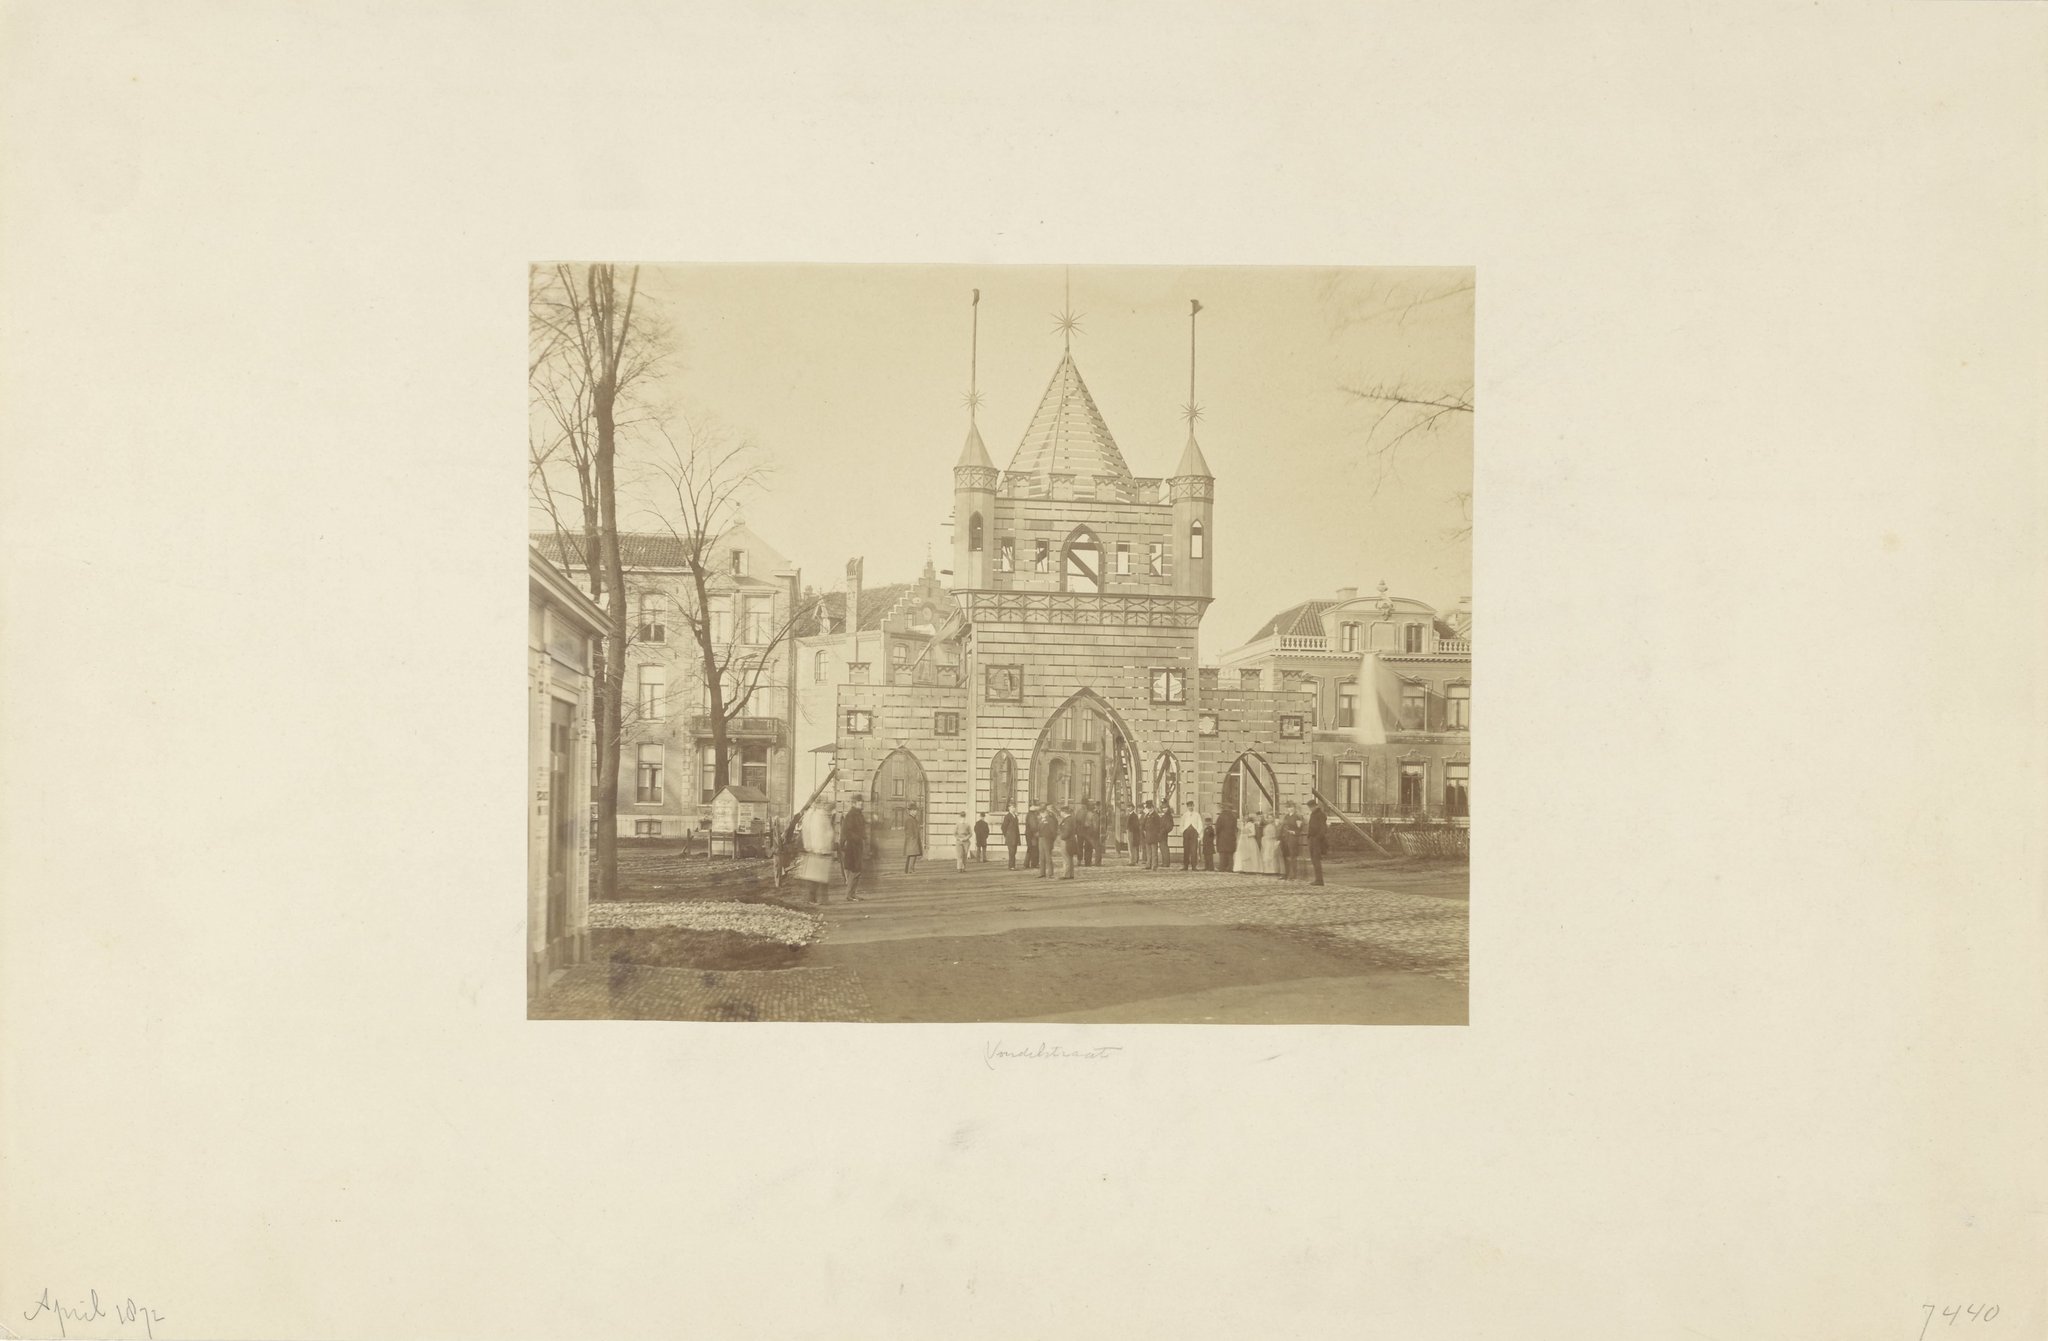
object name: photograph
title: Erepoort bij de ingang van de Vondelstraat te Amsterdam tijdens het Aprilfeest 1872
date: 1872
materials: cardboard, paper, photographic support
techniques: albumen print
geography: amsterdam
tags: public festivities (+ decorated staff, portable structure ~ festive activities), triumphal arch, gate, entrance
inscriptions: inscription: ‘Eigendom Berkhout’, collector's mark: Lugt 2228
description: Gezicht op de erepoort opgericht door de bewoners bij de ingang van de Vondelstraat te Amsterdam tijdens de Aprilfeesten in 1872